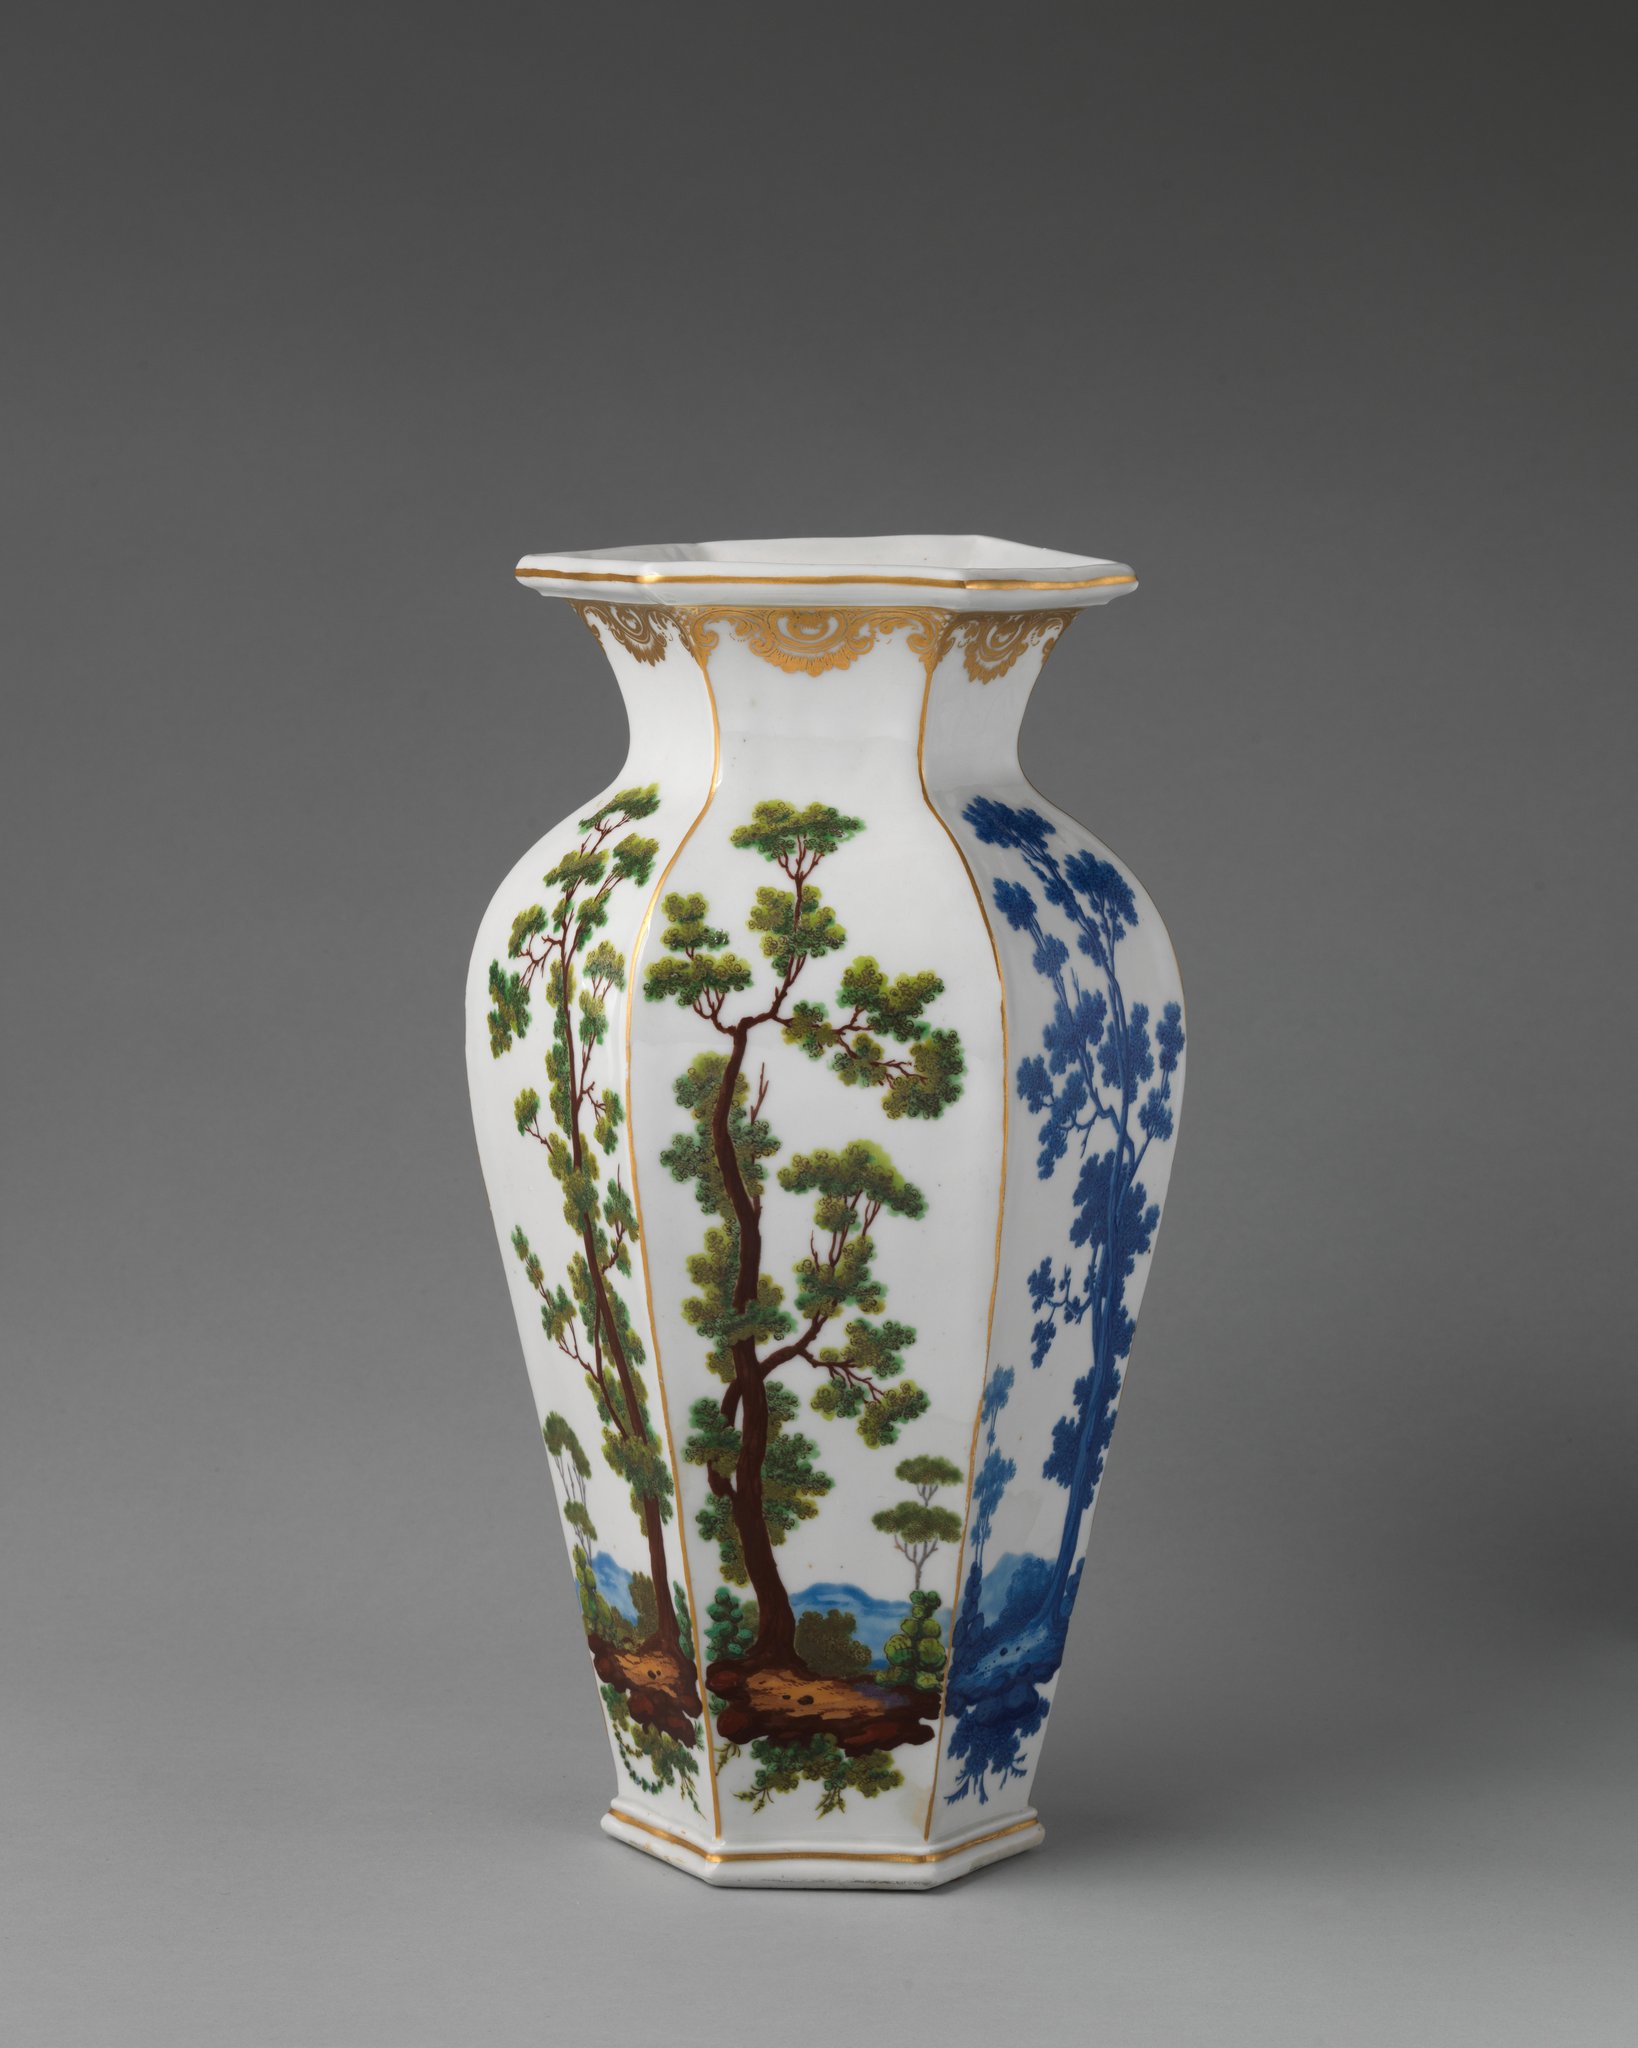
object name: beaker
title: Beaker (part of a garniture)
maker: bristol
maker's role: factory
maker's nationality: british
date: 1773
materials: hard paste porcelain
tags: trees